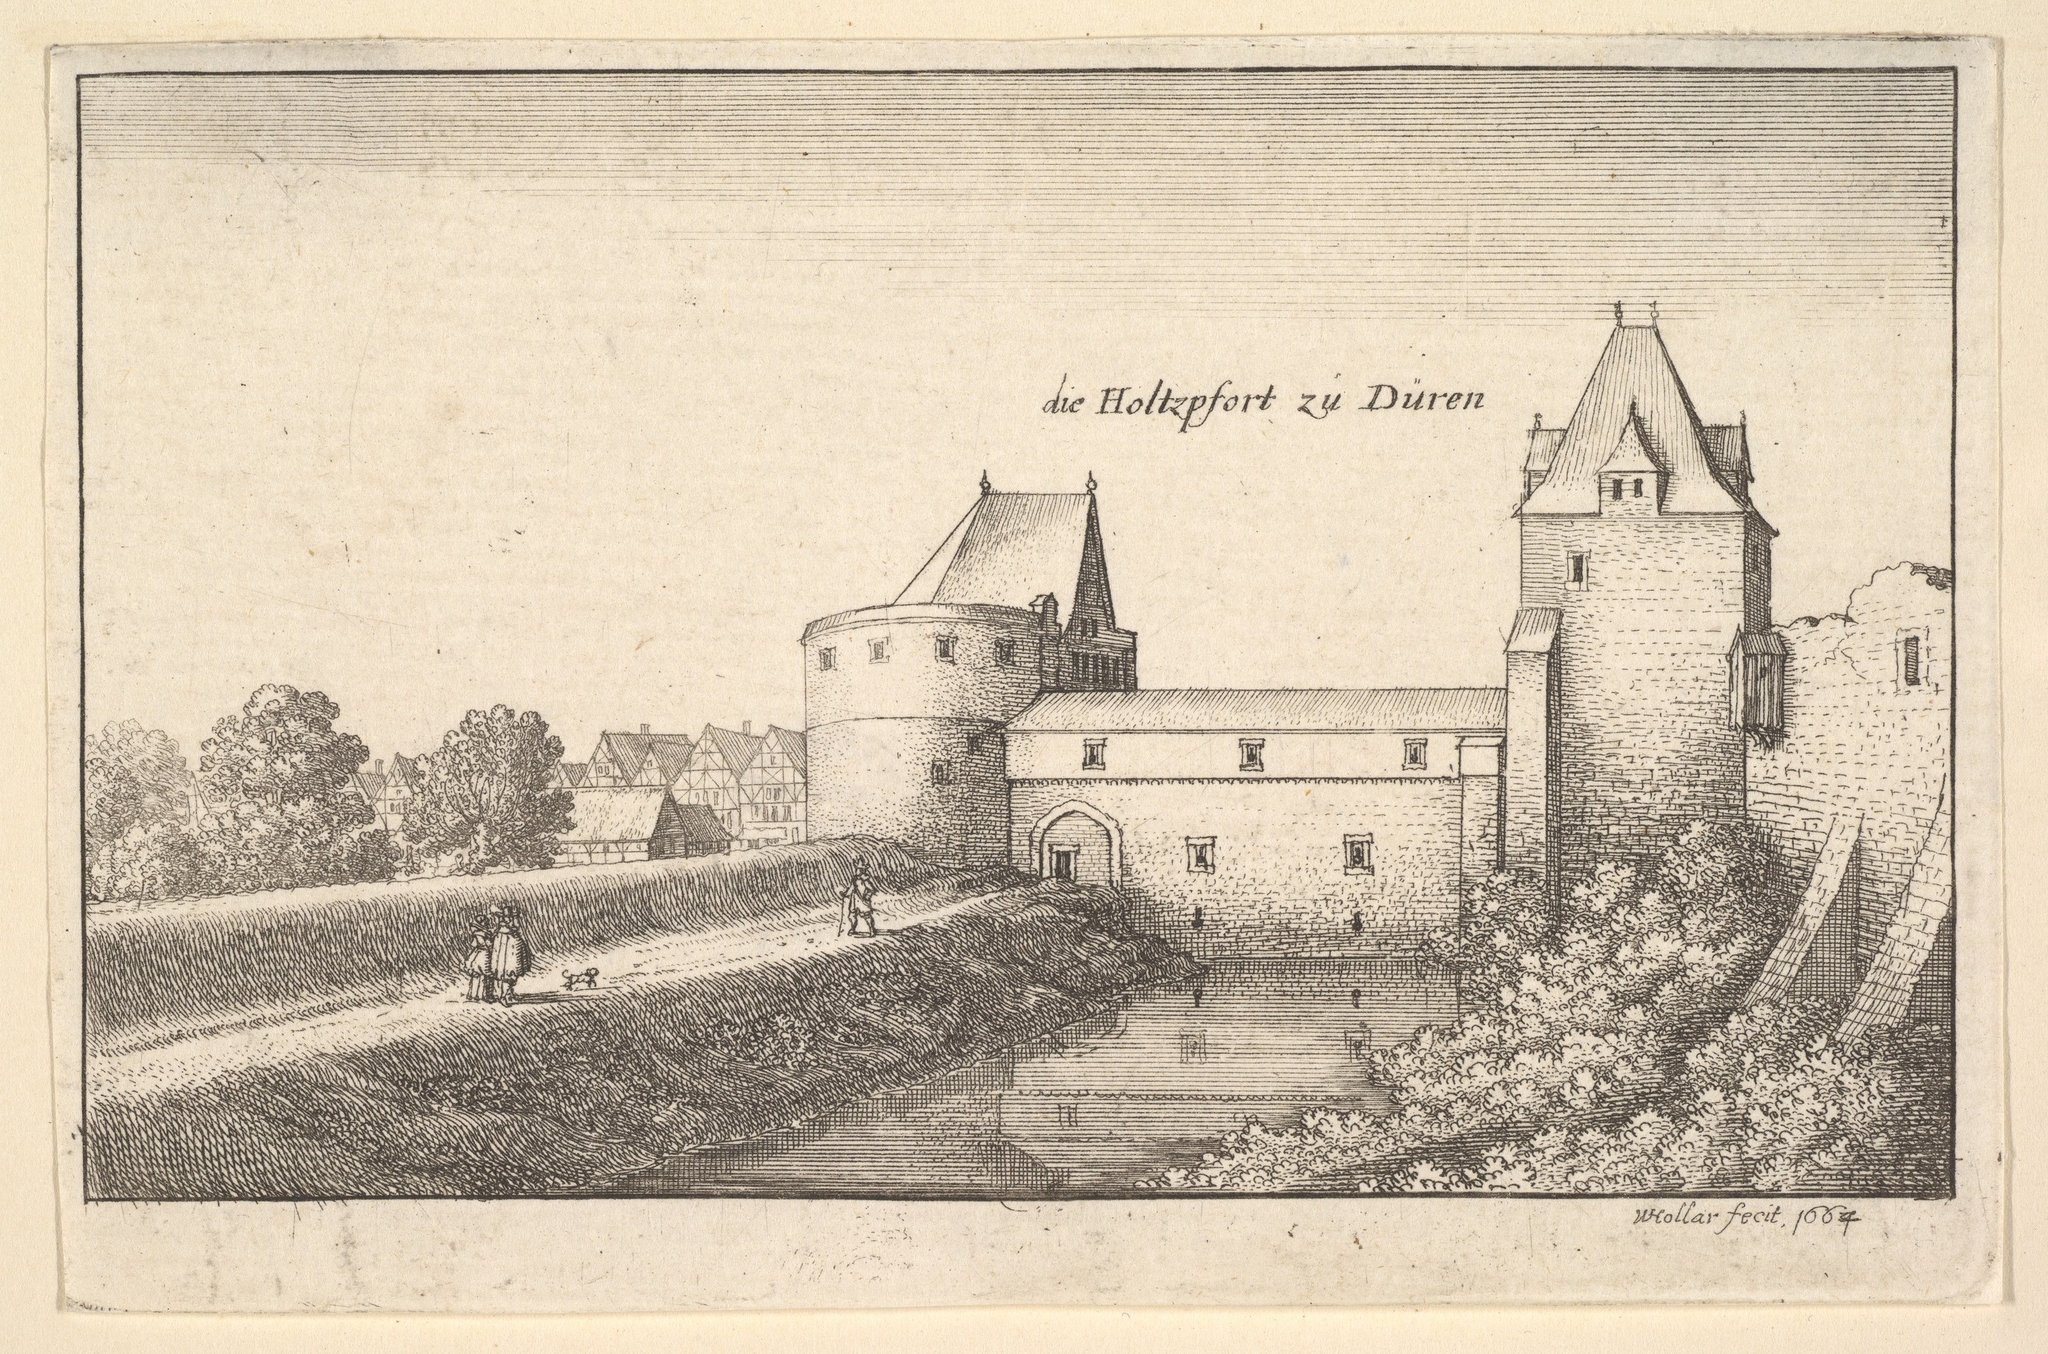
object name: print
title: Fortified gate at Düren, from "European Views"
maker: wenceslaus hollar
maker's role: artist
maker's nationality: bohemian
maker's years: 1607-1677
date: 1664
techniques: etching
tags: human figures,fortification,gates,roads